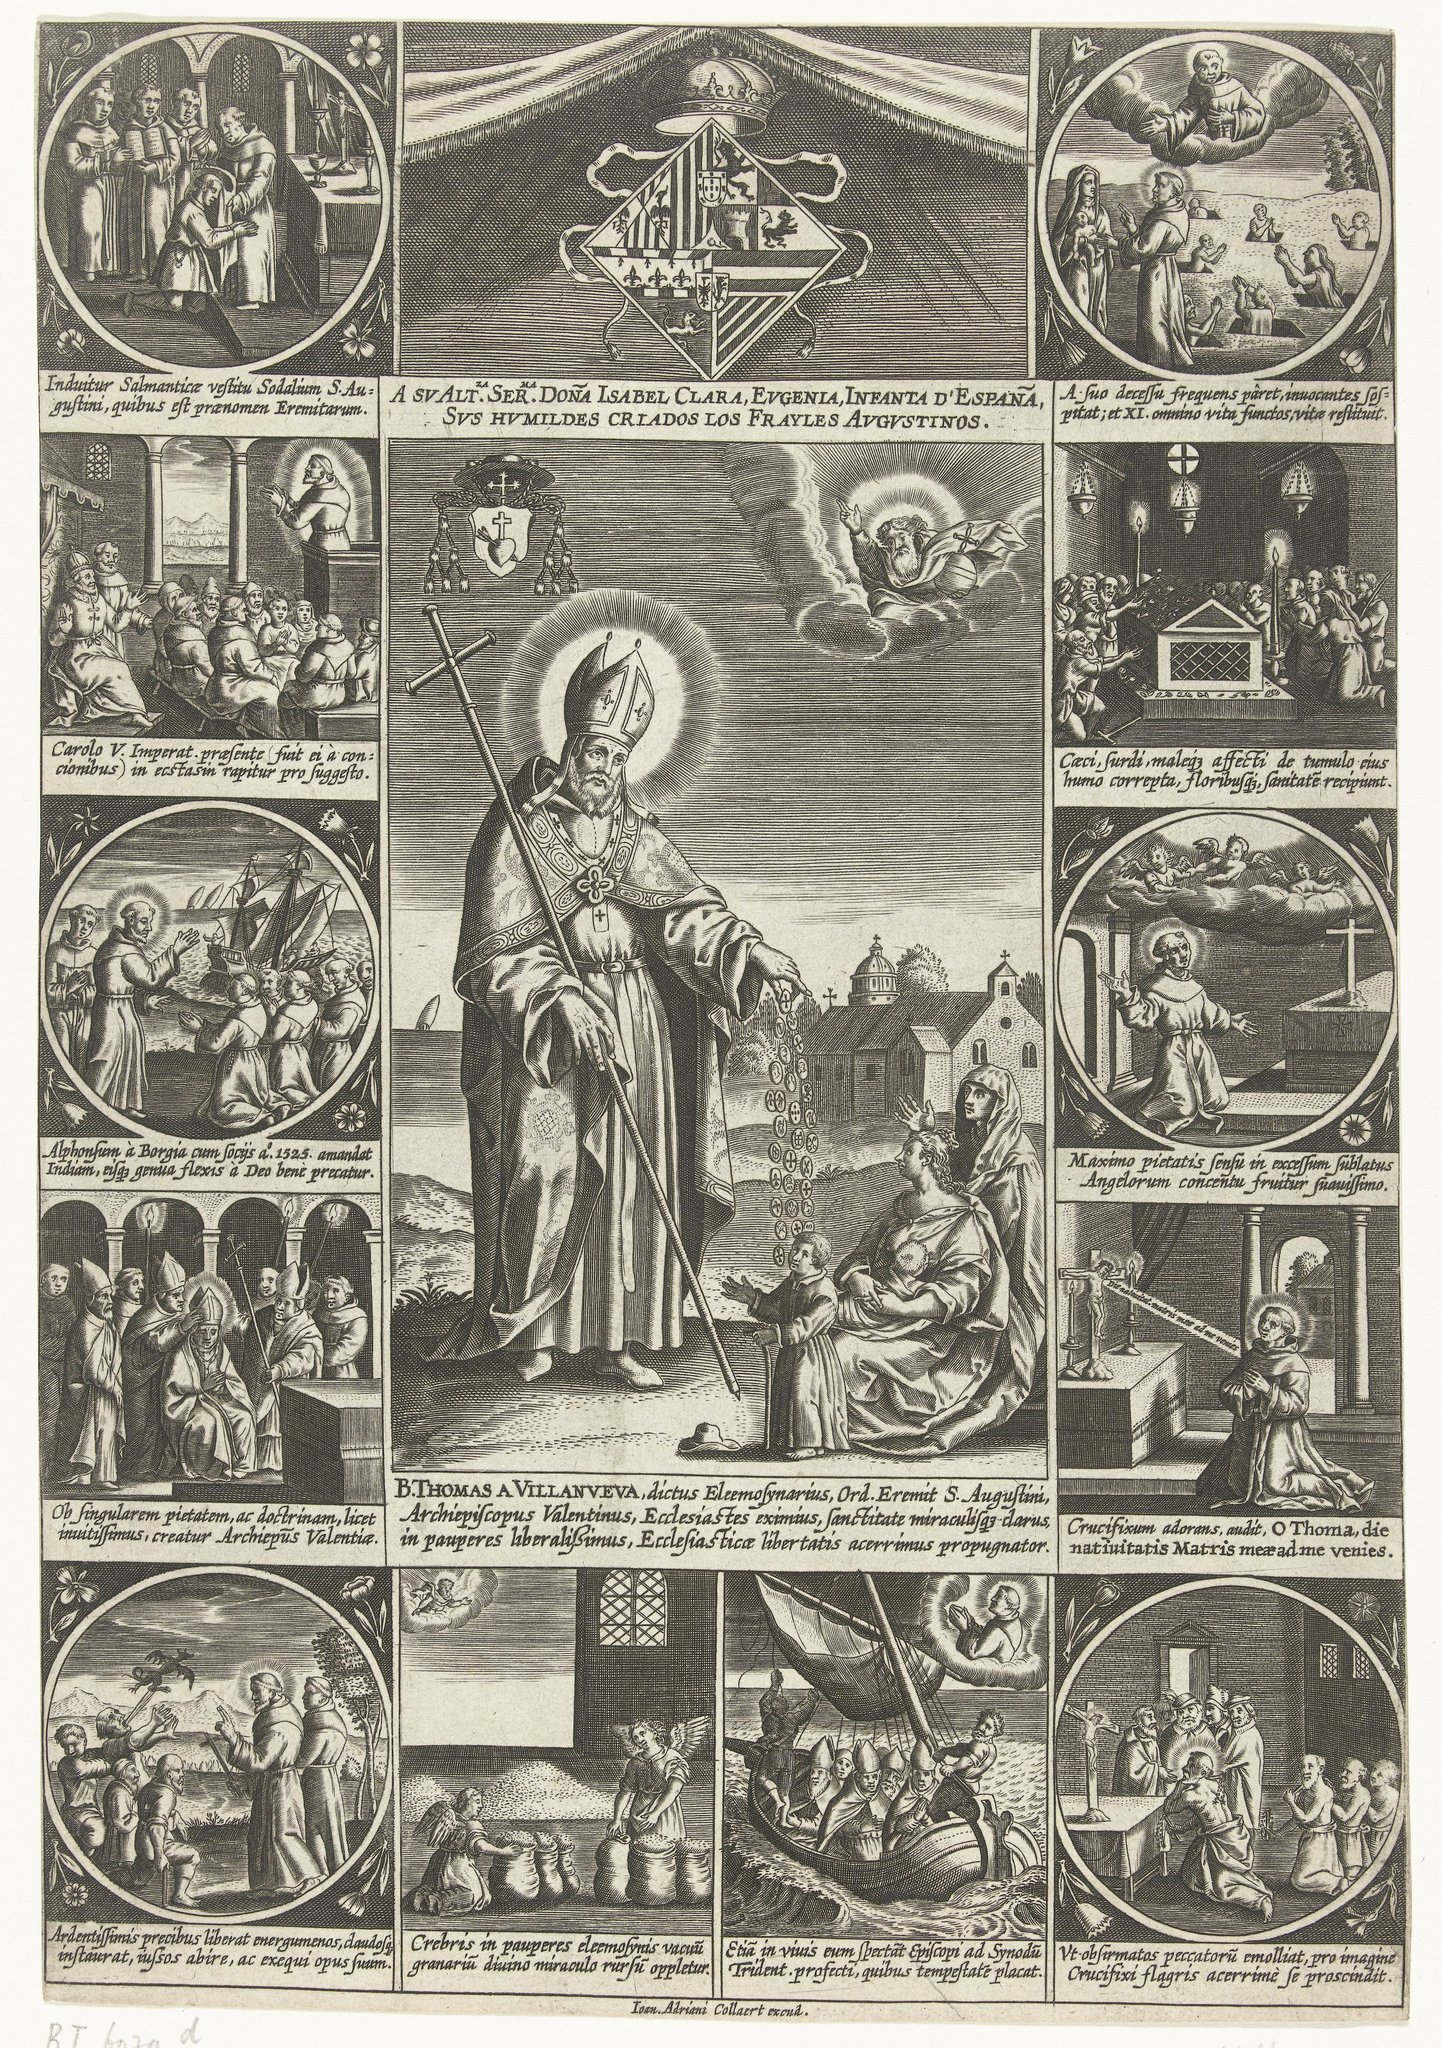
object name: print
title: Scènes uit het leven van de Heilige Thomas van Villanueva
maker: jan baptiste collaert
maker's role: print maker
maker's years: 1591-1627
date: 1601-1627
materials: paper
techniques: engraving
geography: antwerp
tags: the augustinian friar thomas of villanueva, archbishop of valencia; possible attributes: beggars, cripples, purse - posthumous deeds, appearances of male saints, the augustinian friar thomas of villanueva, archbishop of valencia; possible attributes: beggars, cripples, purse - miraculous activities and events ~ male saint, non-miraculous activities and events ~ st. thomas of villanueva, the augustinian friar thomas of villanueva, archbishop of valencia; possible attributes: beggars, cripples, purse (+ god the father in the form of light)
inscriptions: inscription: ‘38. - 11.’, collector's mark: Lugt 240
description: Centraal de Heilige Thomas van Villanueva die geld uitdeelt aan de armen. Boven in de wolken zegent God hem. Rondom de afbeelding twaalf scènes uit het leven van de Heilige Thomas van Villanueva. Bovenaan in het midden het wapenschild van Isabella van Oostenrijk. De prent heeft verschillende Latijnse onderschriften.